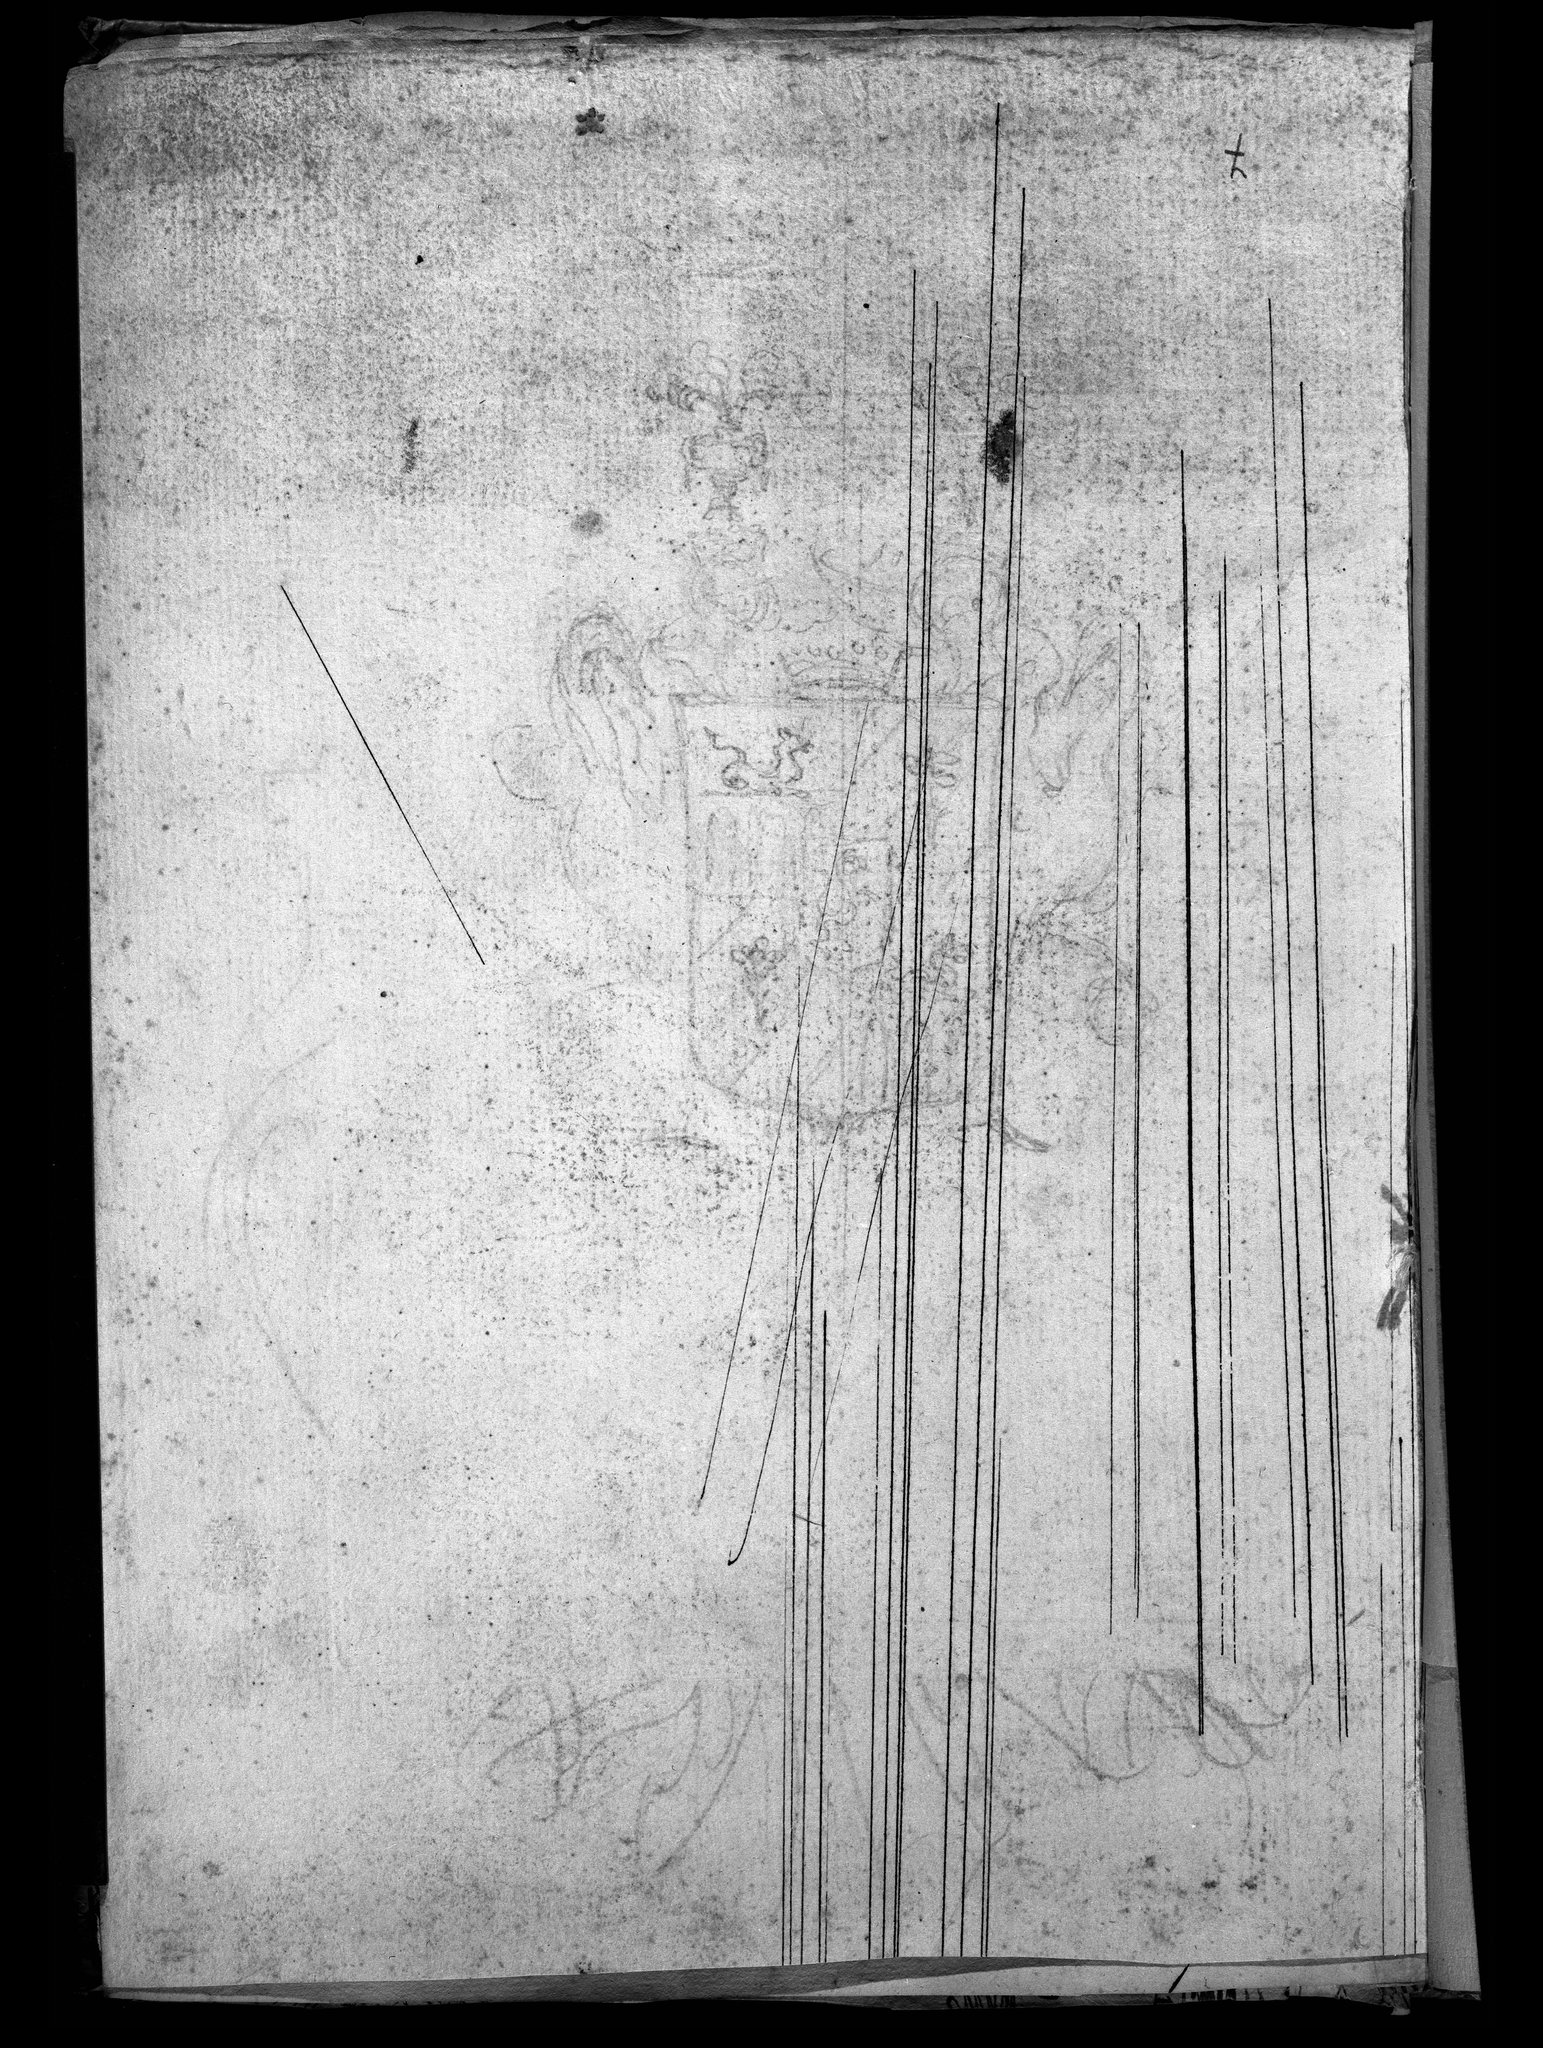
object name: collection ornament architecture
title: Album of Drawings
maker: filippo juvarra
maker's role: artist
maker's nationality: italian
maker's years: 1678-1736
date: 1678-1736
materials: chalk, ink, paper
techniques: brush, pen, transfer, wash